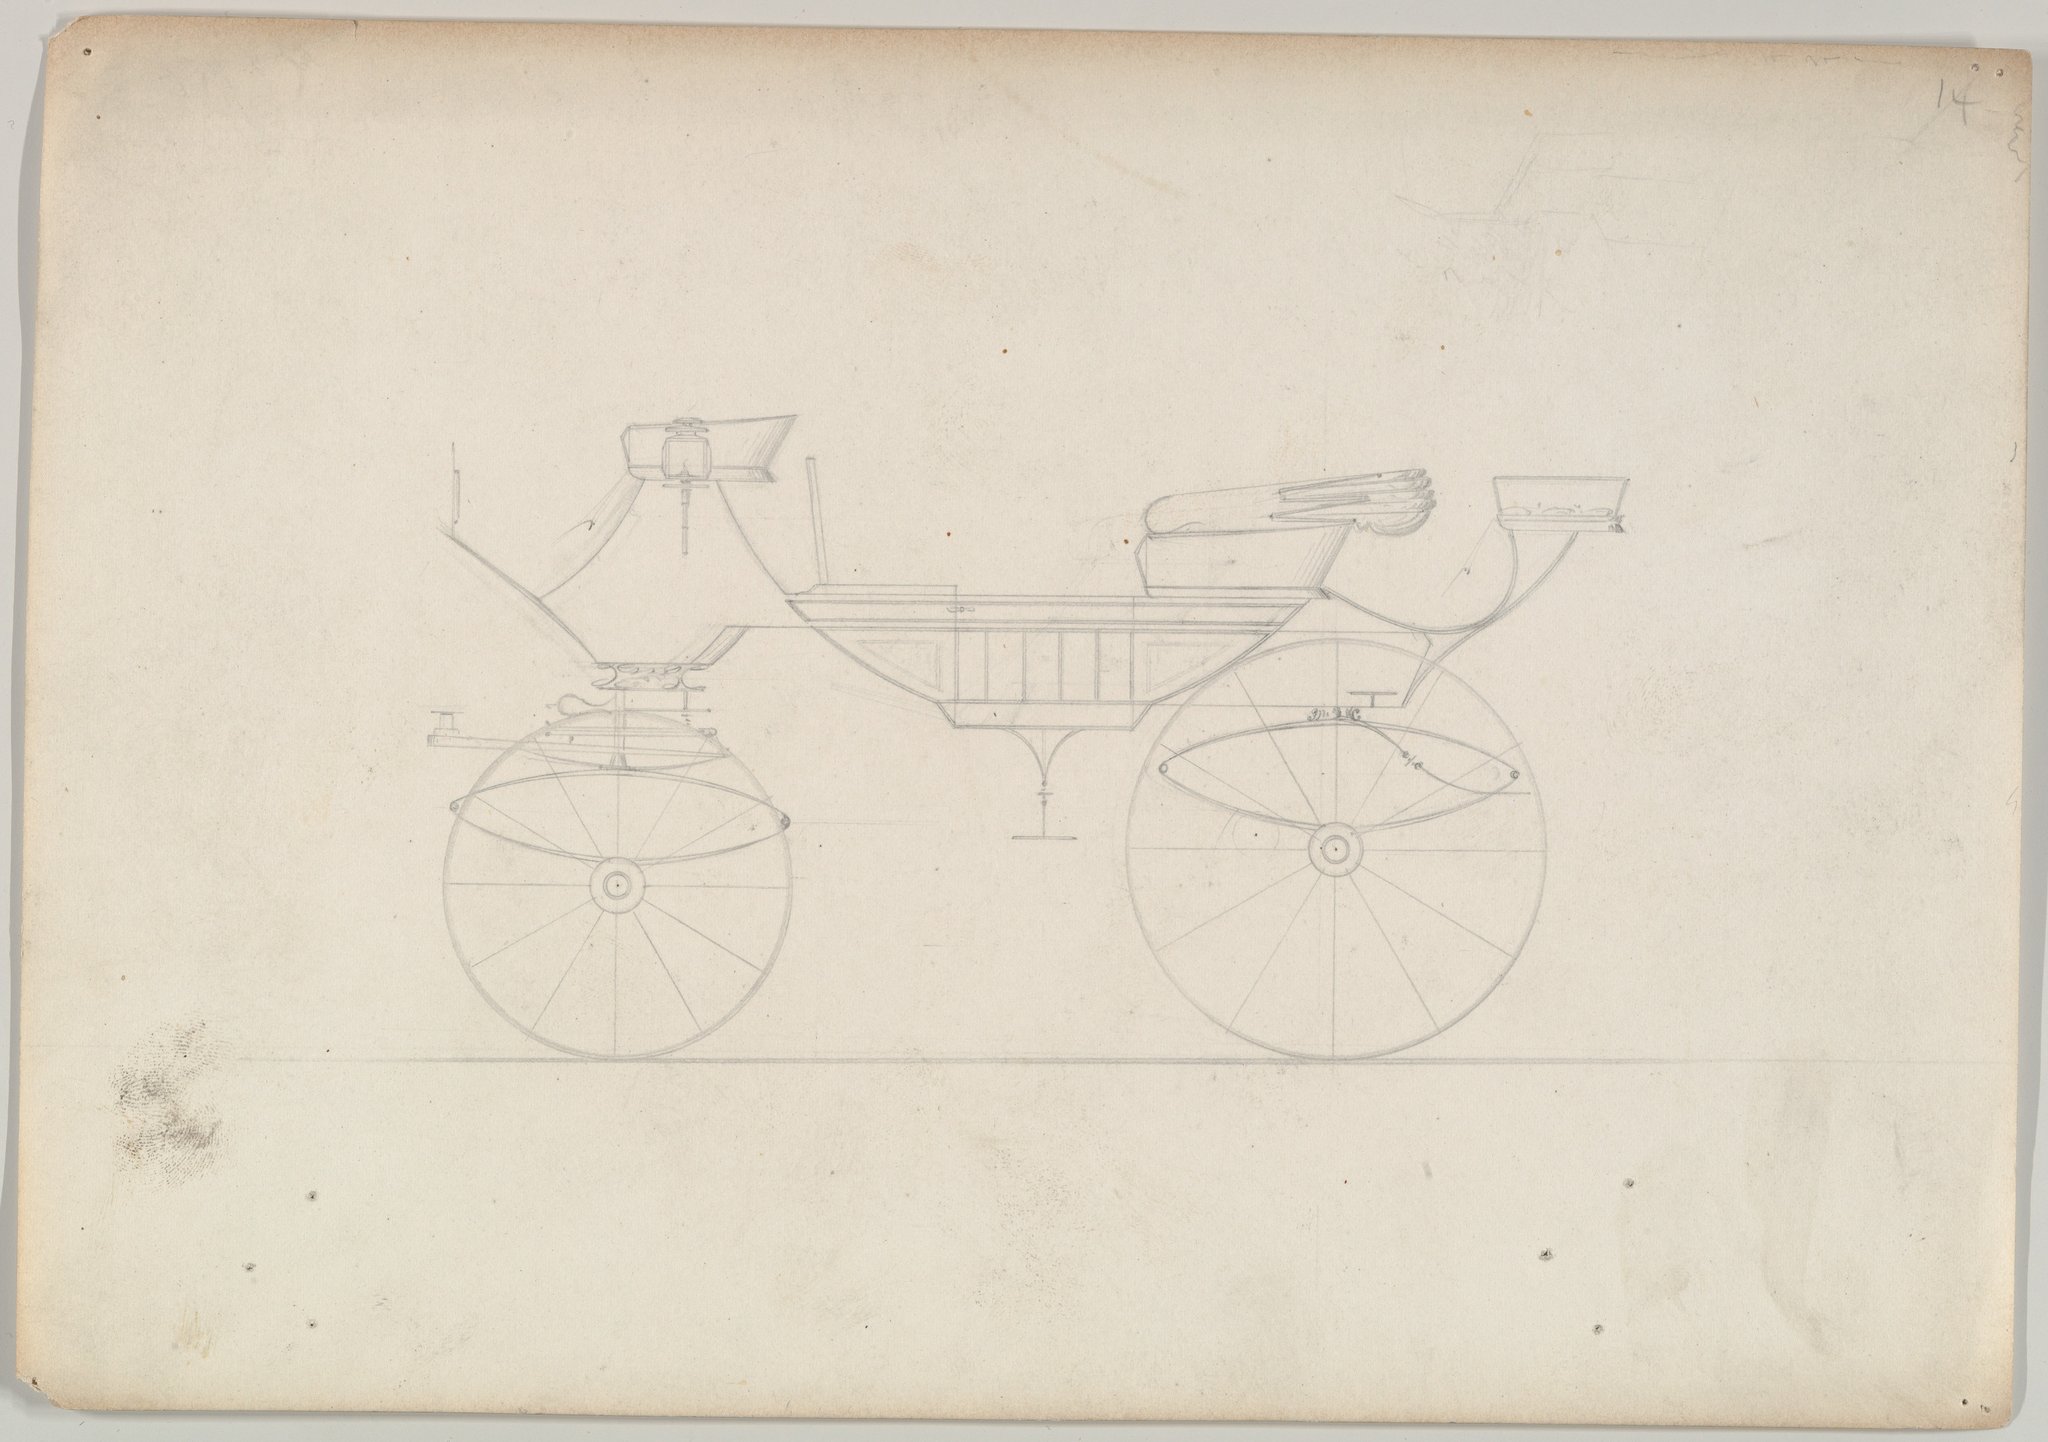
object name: drawing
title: Design for Sociable/ Vis-à-Vis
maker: brewster & co.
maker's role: manufacturer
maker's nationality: american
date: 1850-1870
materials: graphite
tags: carriages